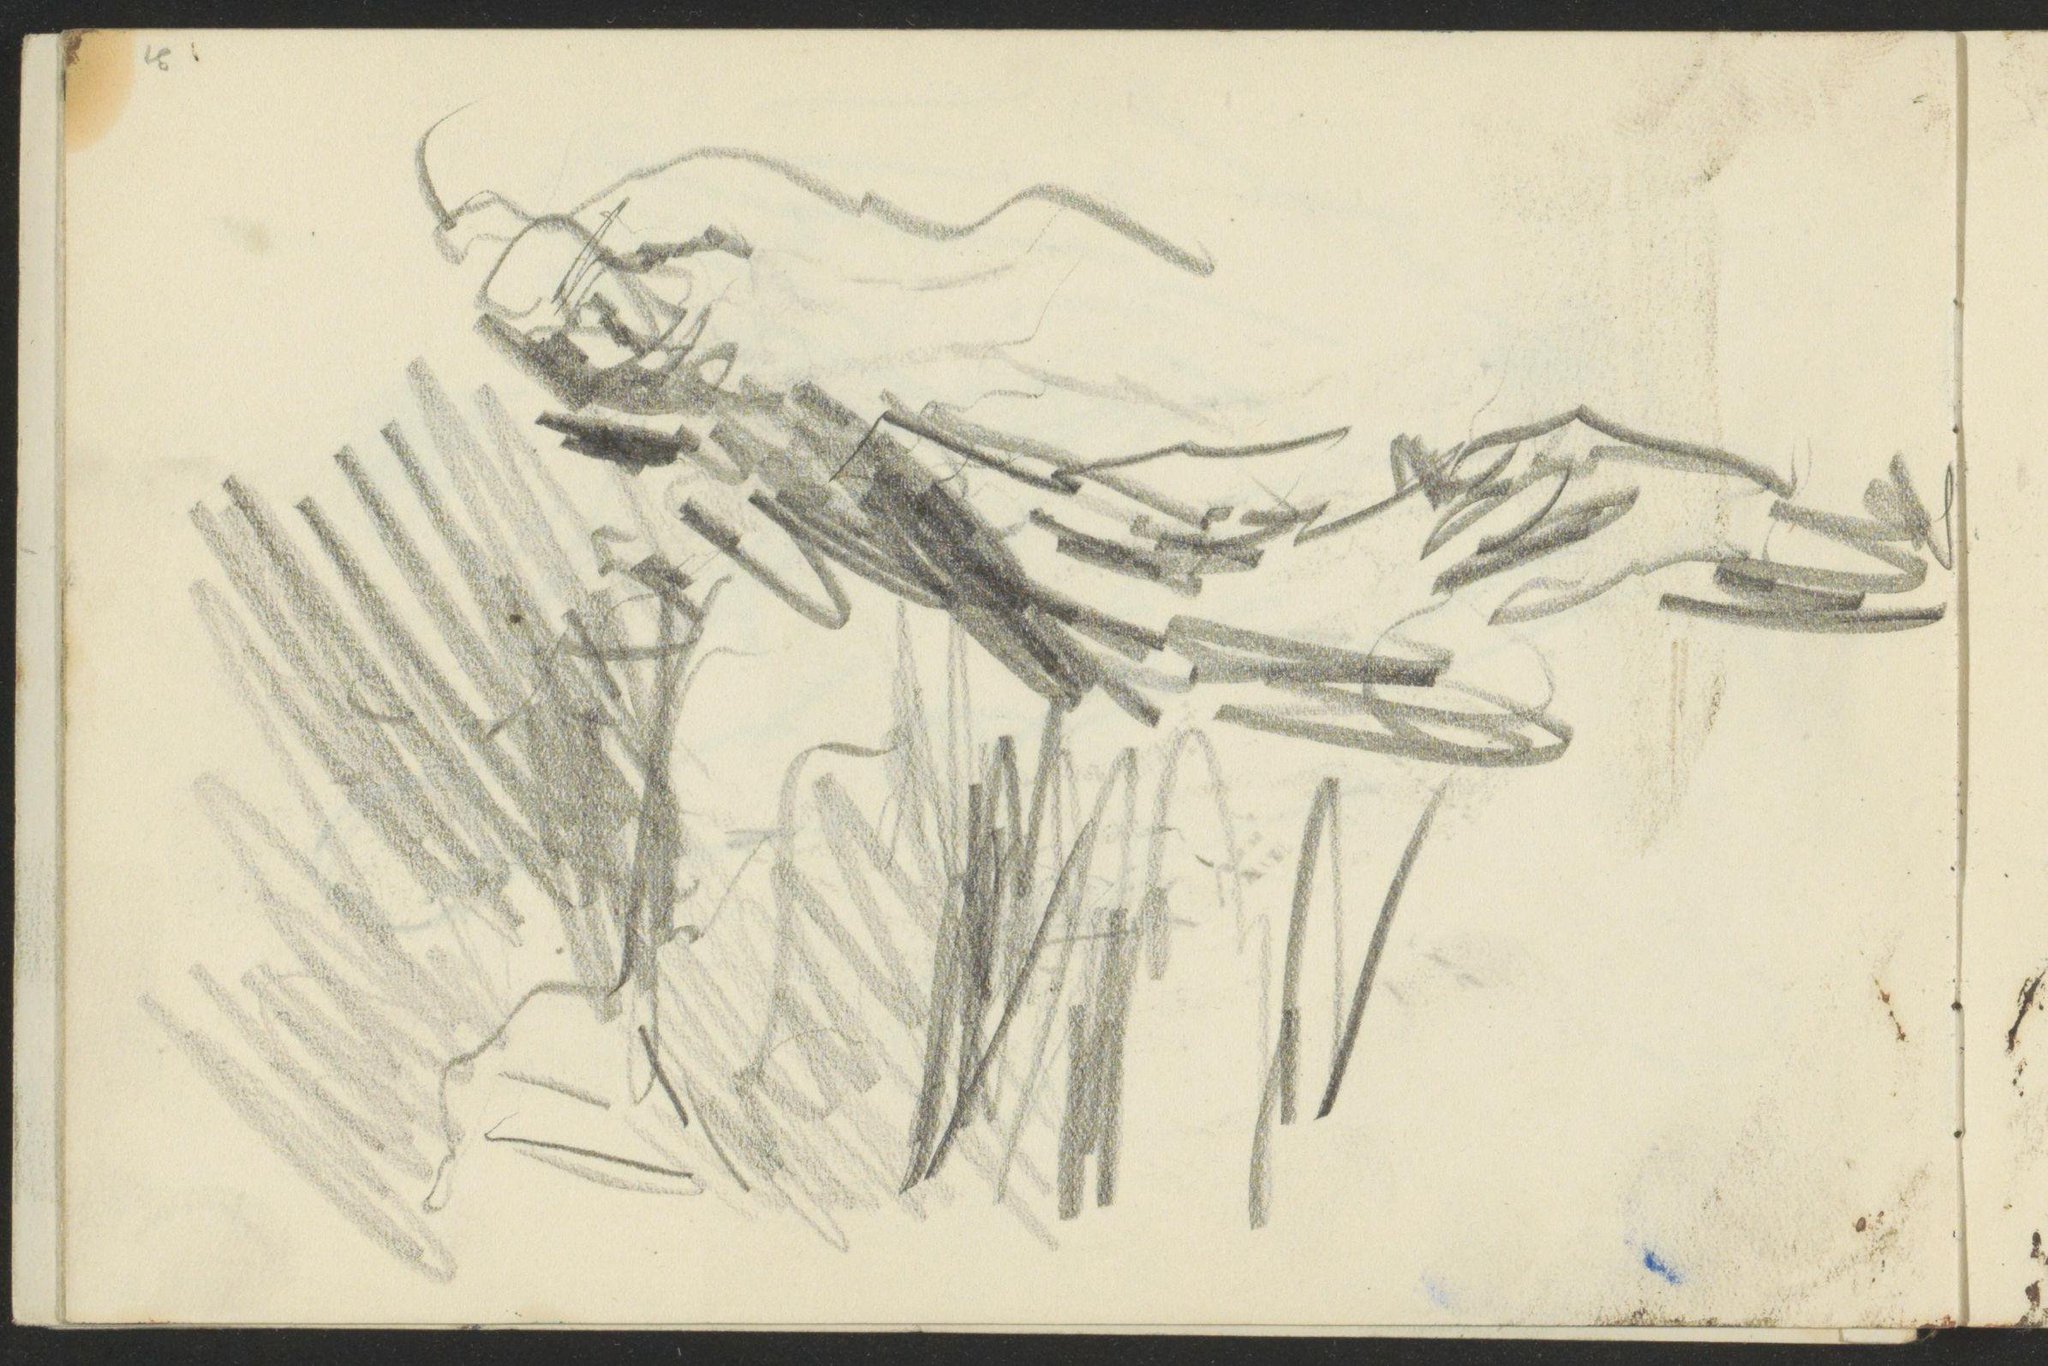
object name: sketchbook leaf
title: Staande figuren, mogelijk artiesten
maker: isaac israels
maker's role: draughtsman, painter, print maker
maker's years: 1865-1934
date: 1875-1934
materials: paper, pencil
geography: the hague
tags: standing figure, adult man (+ standing), cabaret-artiste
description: Onder andere een man in jacquet. Blad 10 verso uit schetsboek LXI met 20 bladen.